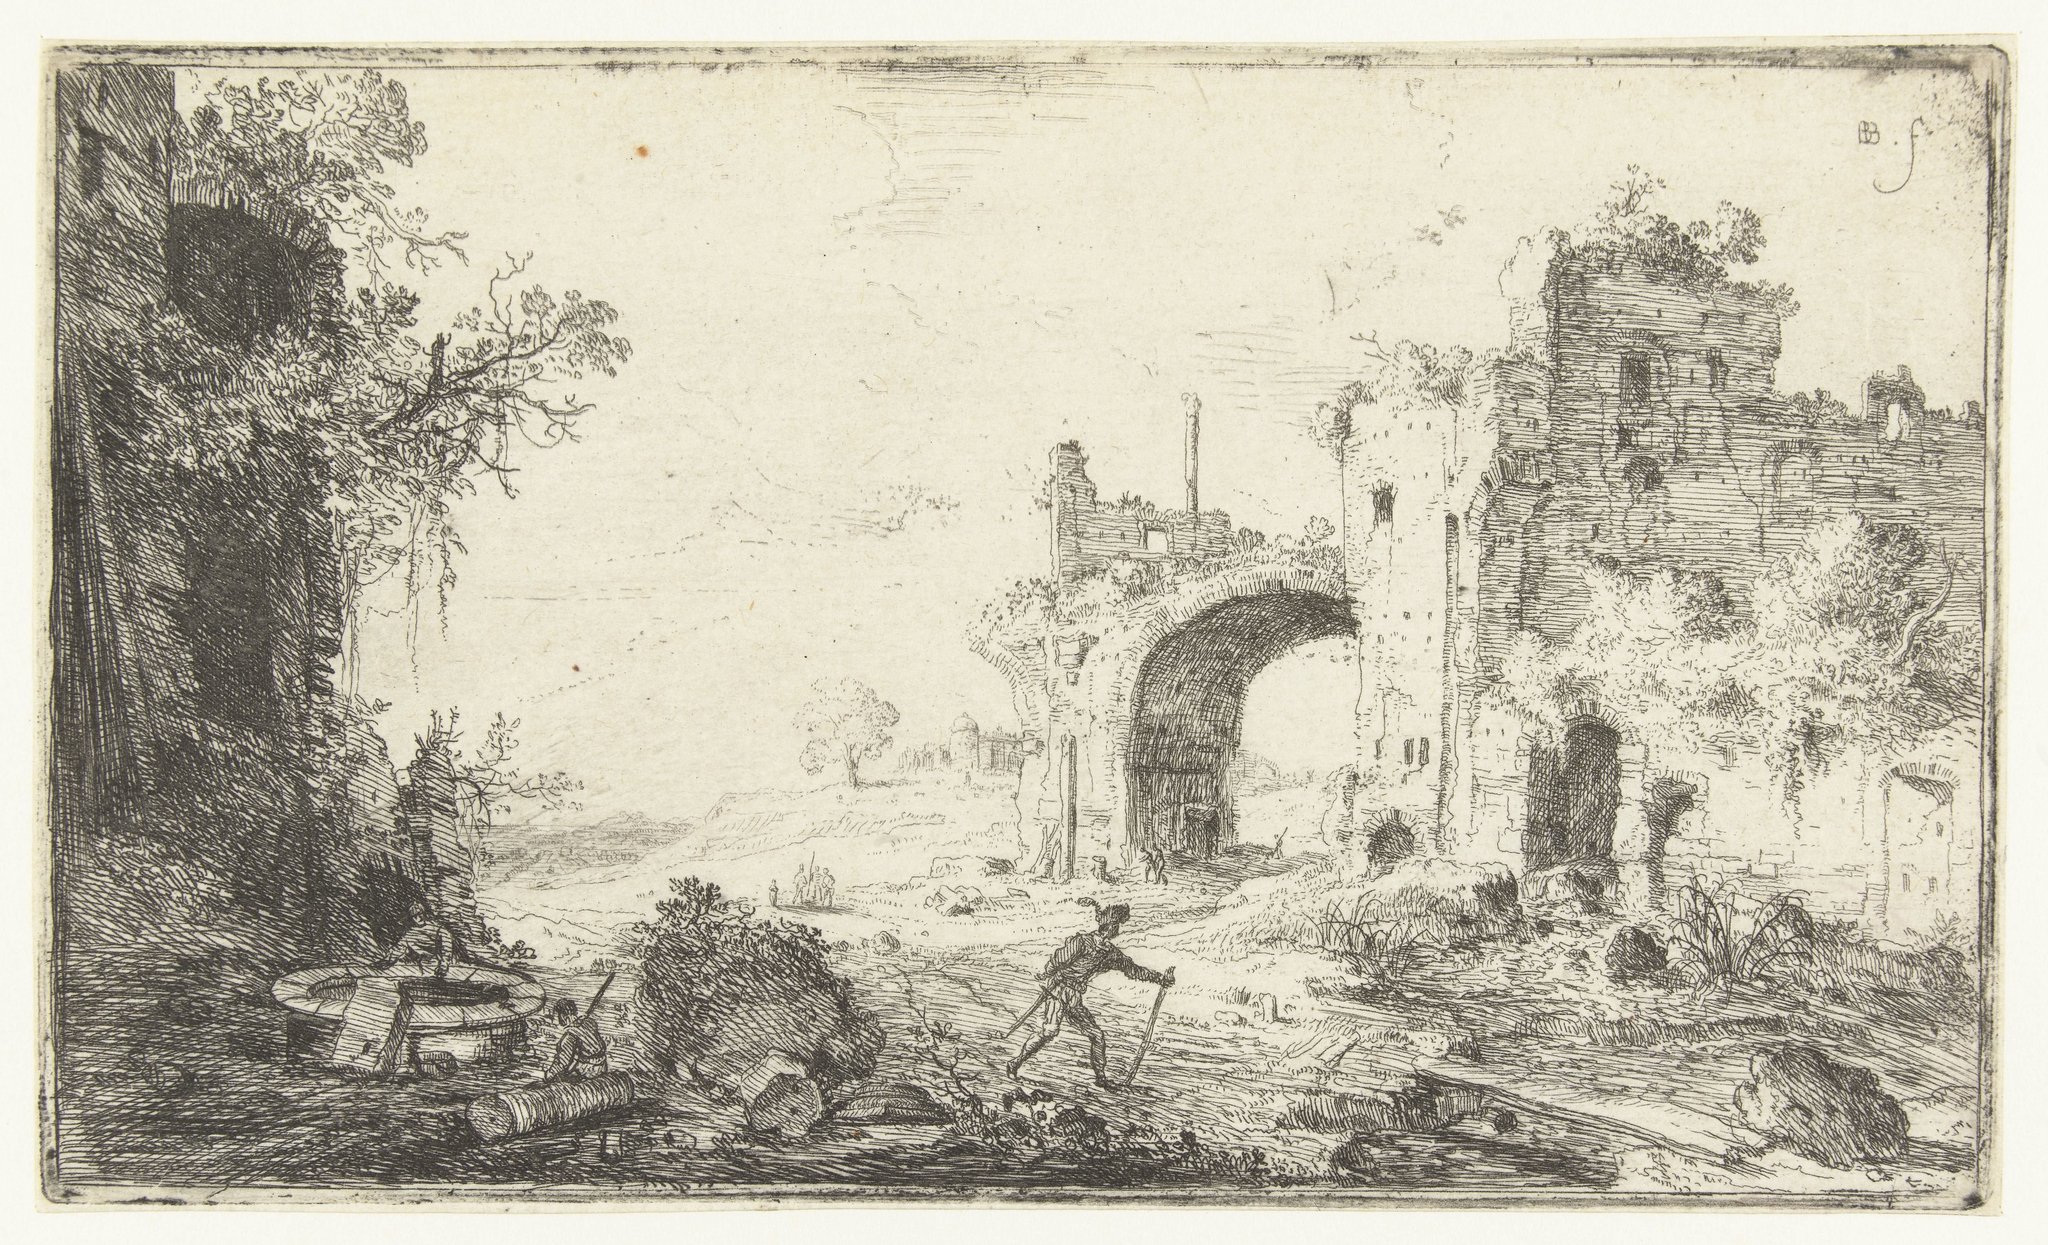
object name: print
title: De zich haastende bode bij de ruïnes van de thermen van Caracalla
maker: bartholomeus breenbergh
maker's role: draughtsman, print maker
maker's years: 1599-1657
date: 1638-1642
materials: paper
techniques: etching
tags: landscape with ruins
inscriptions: collector's mark: Lugt 240